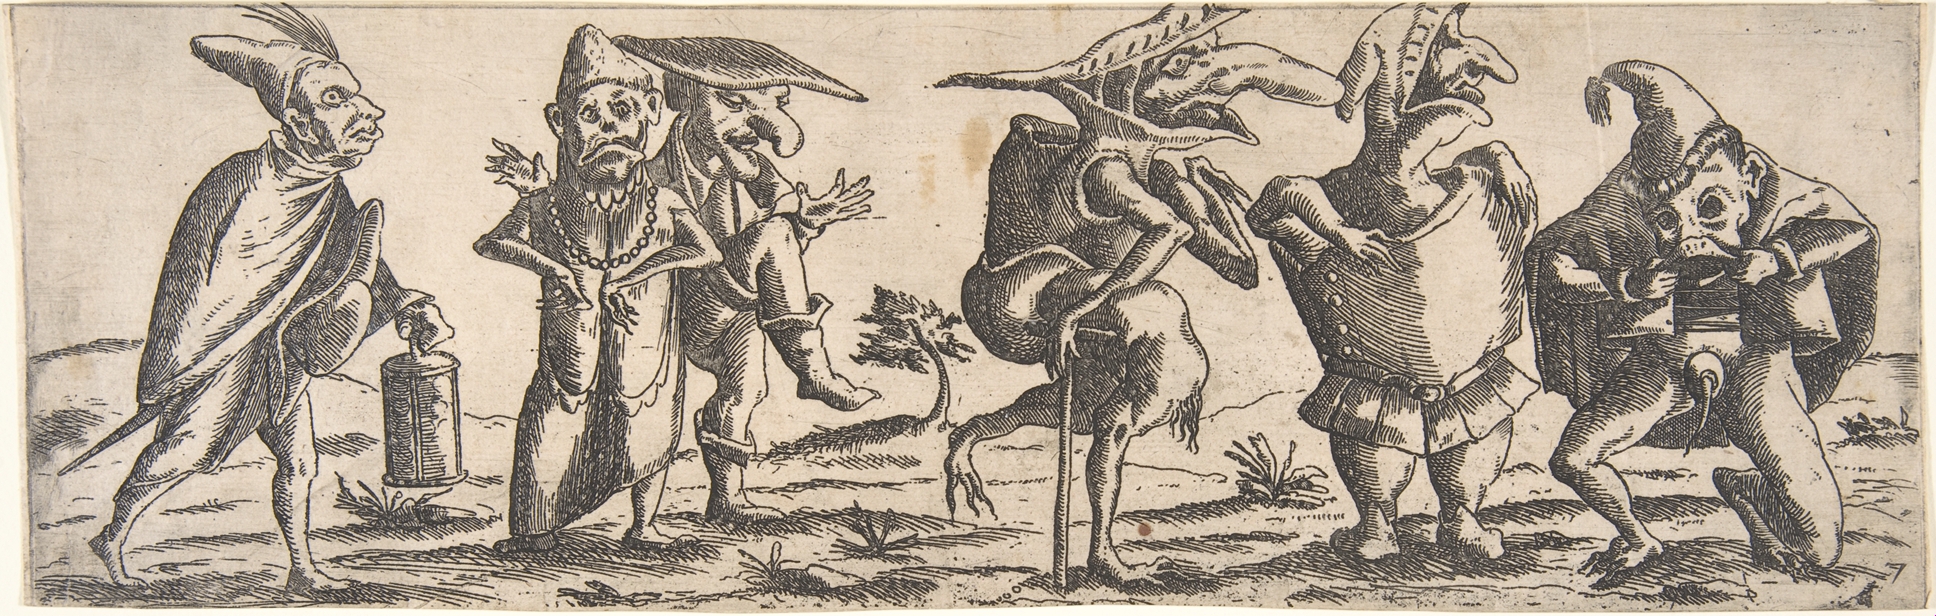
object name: print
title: Procession of Monstrous Figures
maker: wendel dietterlin, the younger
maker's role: artist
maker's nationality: german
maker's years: 1614-1669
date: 1615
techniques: etching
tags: monsters